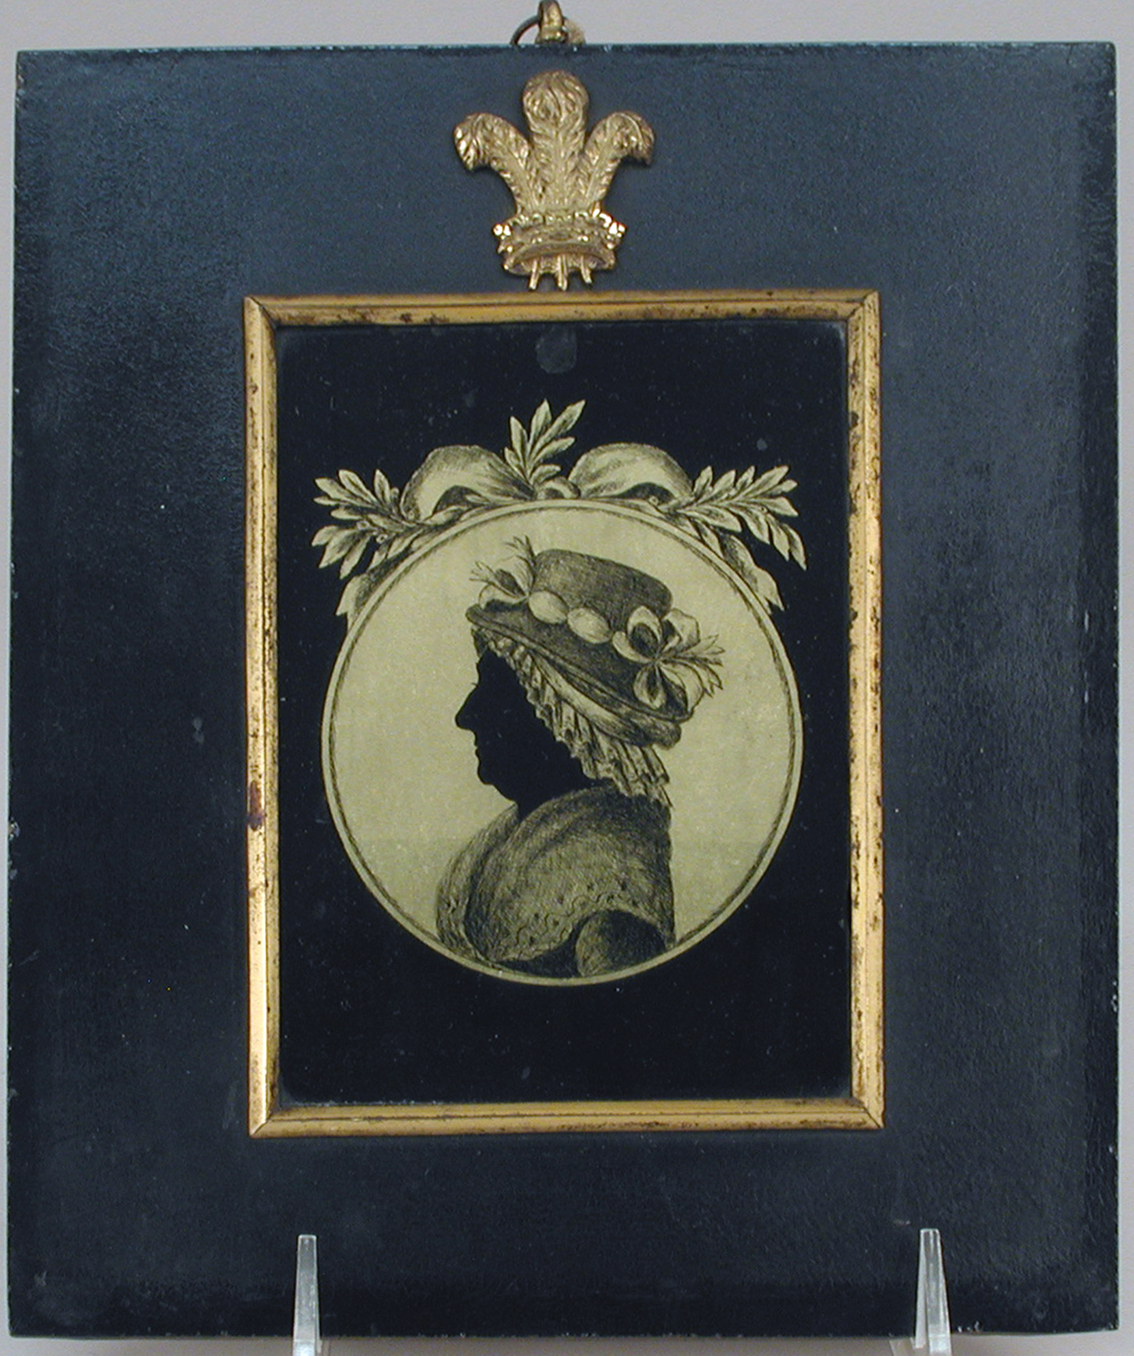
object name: panel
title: Portrait of a woman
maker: aug. forberger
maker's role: artist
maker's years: 1762-1865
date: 1795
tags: profiles,women